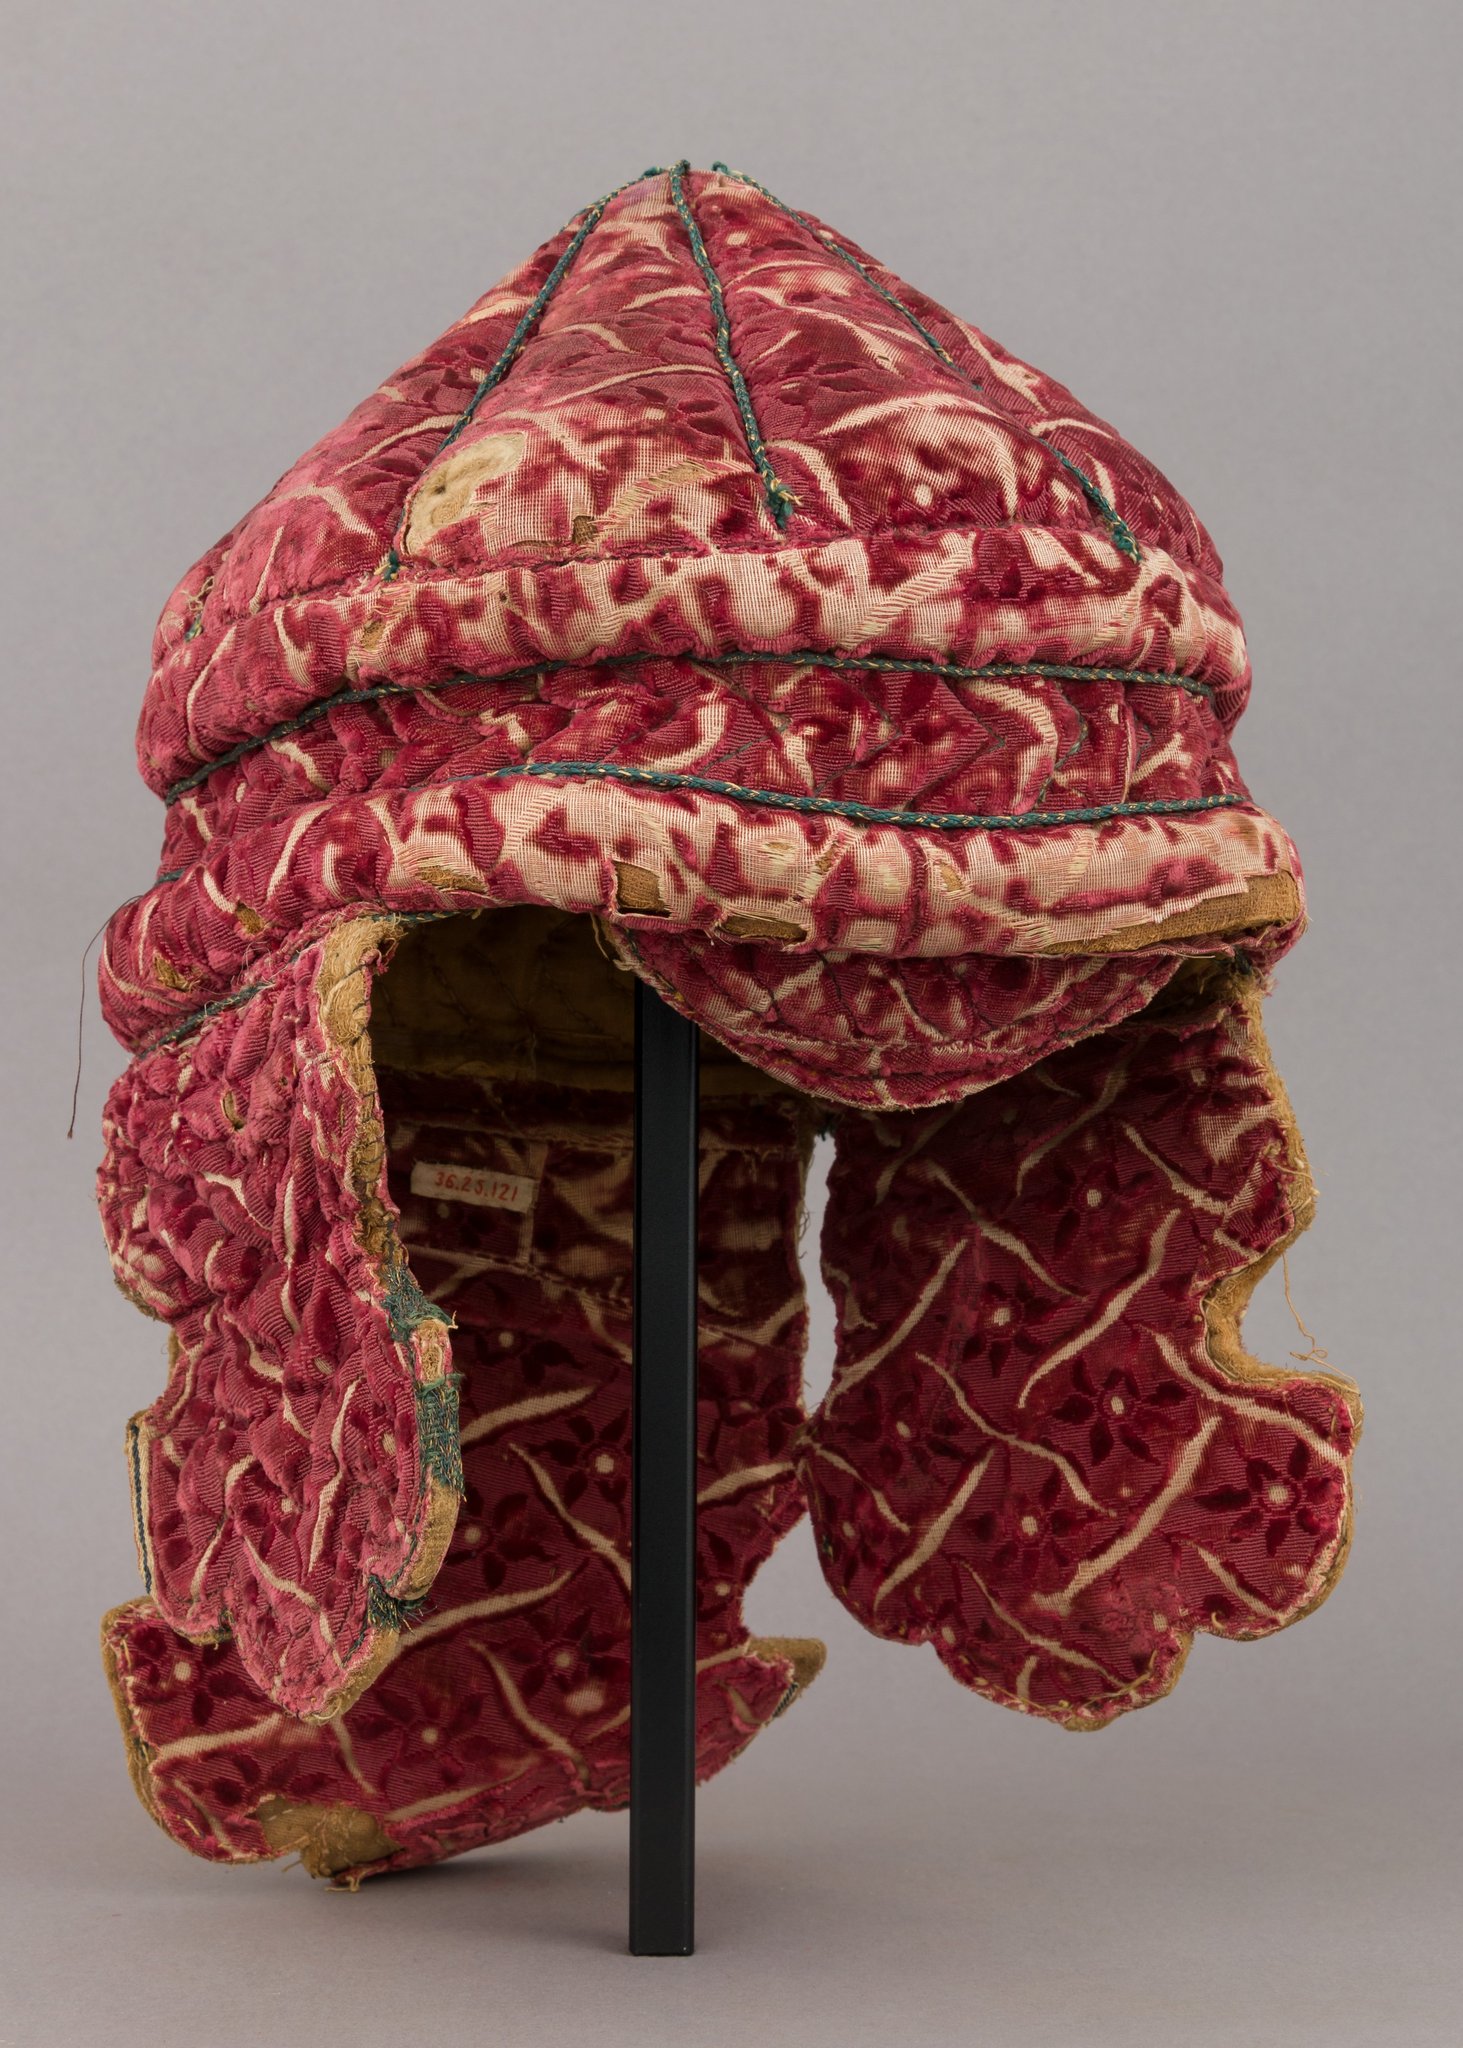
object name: helmet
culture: central indian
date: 1701-1800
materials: textile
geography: central india